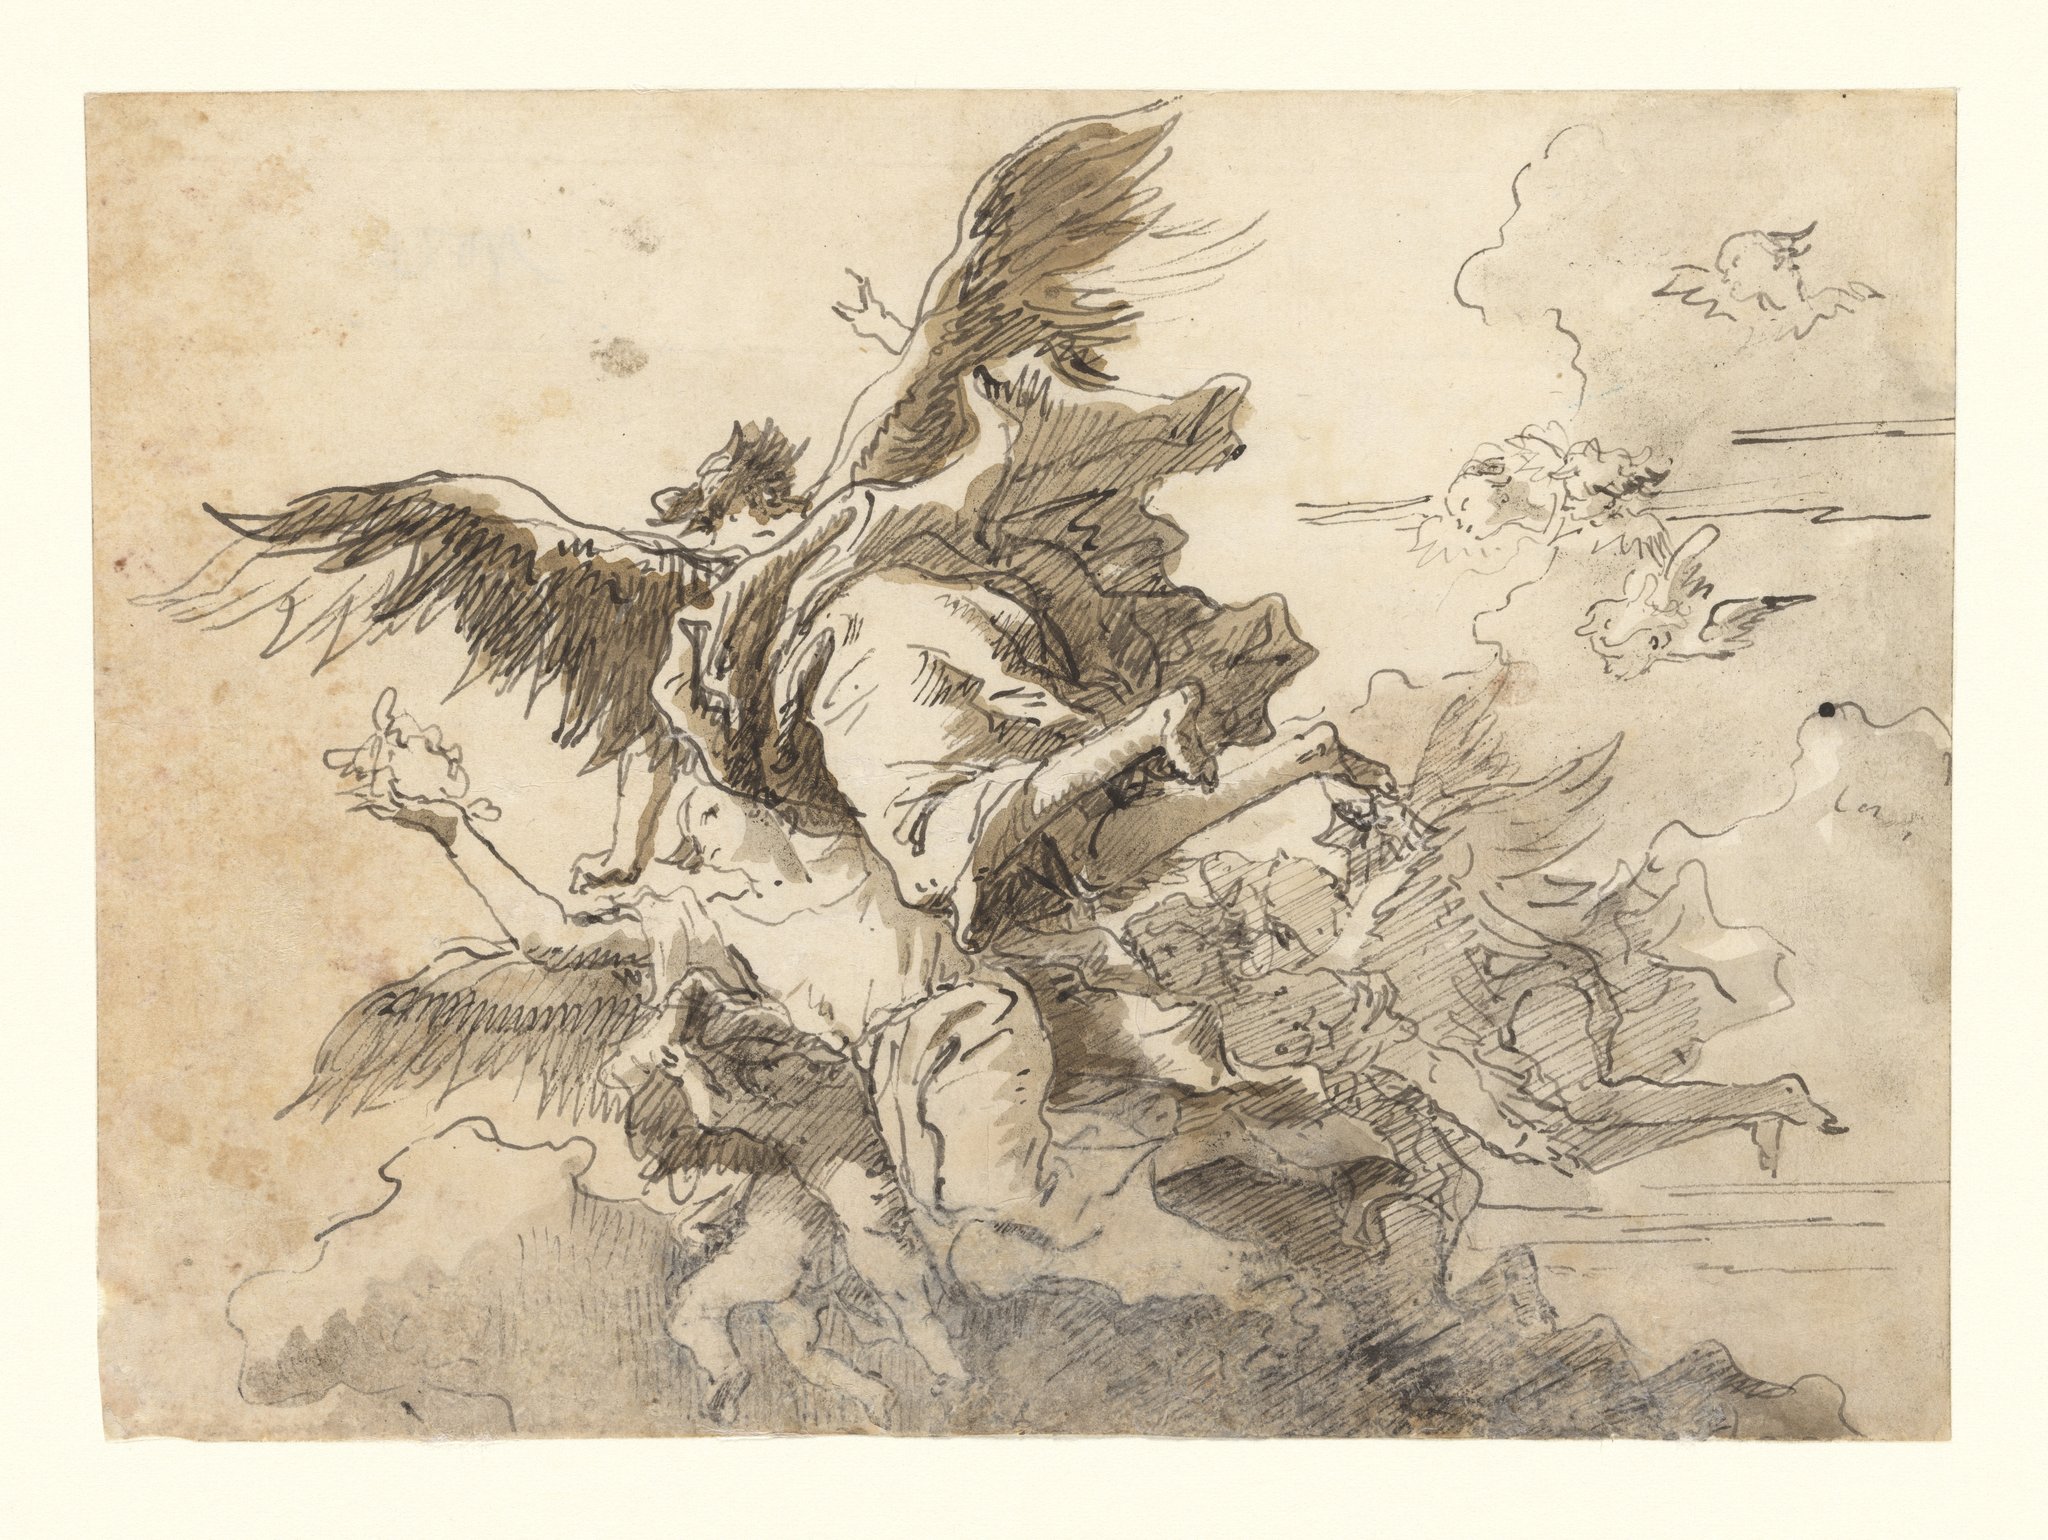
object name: drawing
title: Angels in the Sky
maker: giovanni domenico tiepolo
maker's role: artist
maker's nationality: italian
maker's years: 1727-1804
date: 1762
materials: ink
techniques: pen, wash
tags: angels